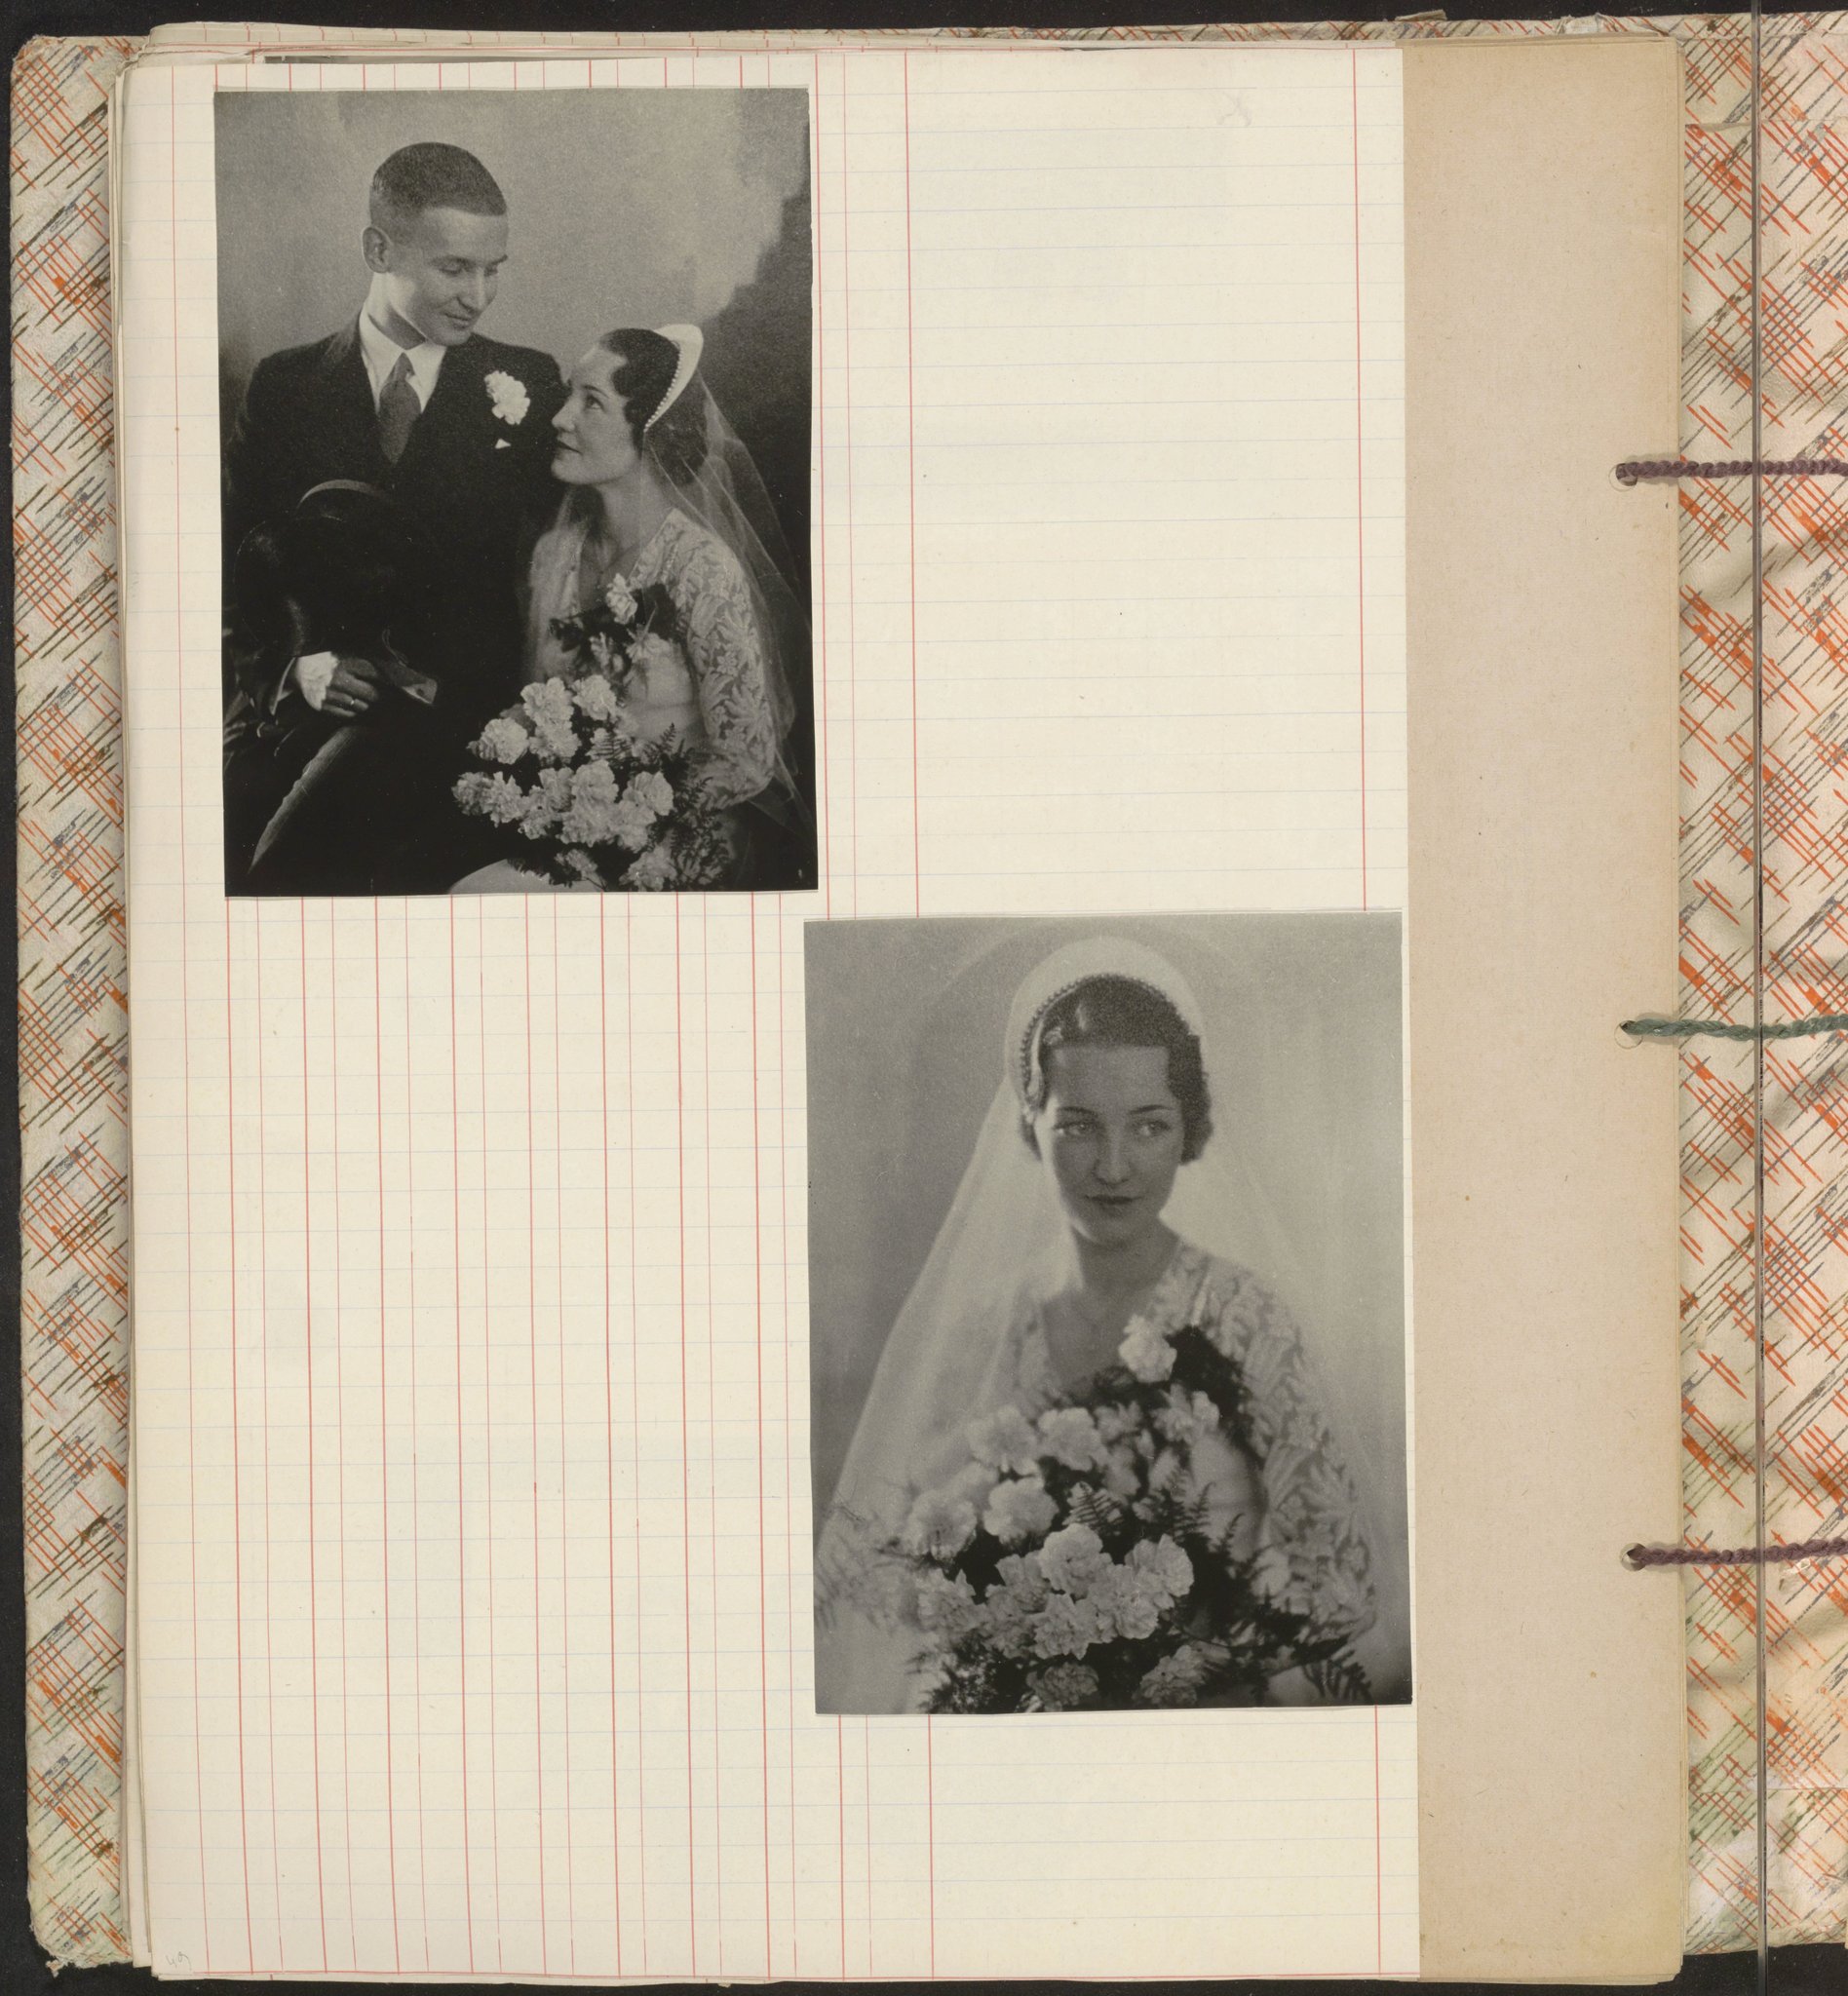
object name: album leaf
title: Huwelijksportretten van een onbekend stel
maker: Anonymous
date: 1920-1940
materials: paper, photographic support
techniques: gelatin silver print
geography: netherlands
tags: adult woman, adult man, marriage, married couple, 'matrimonium'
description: Onderdeel van Fotoalbum van de familie Petri.